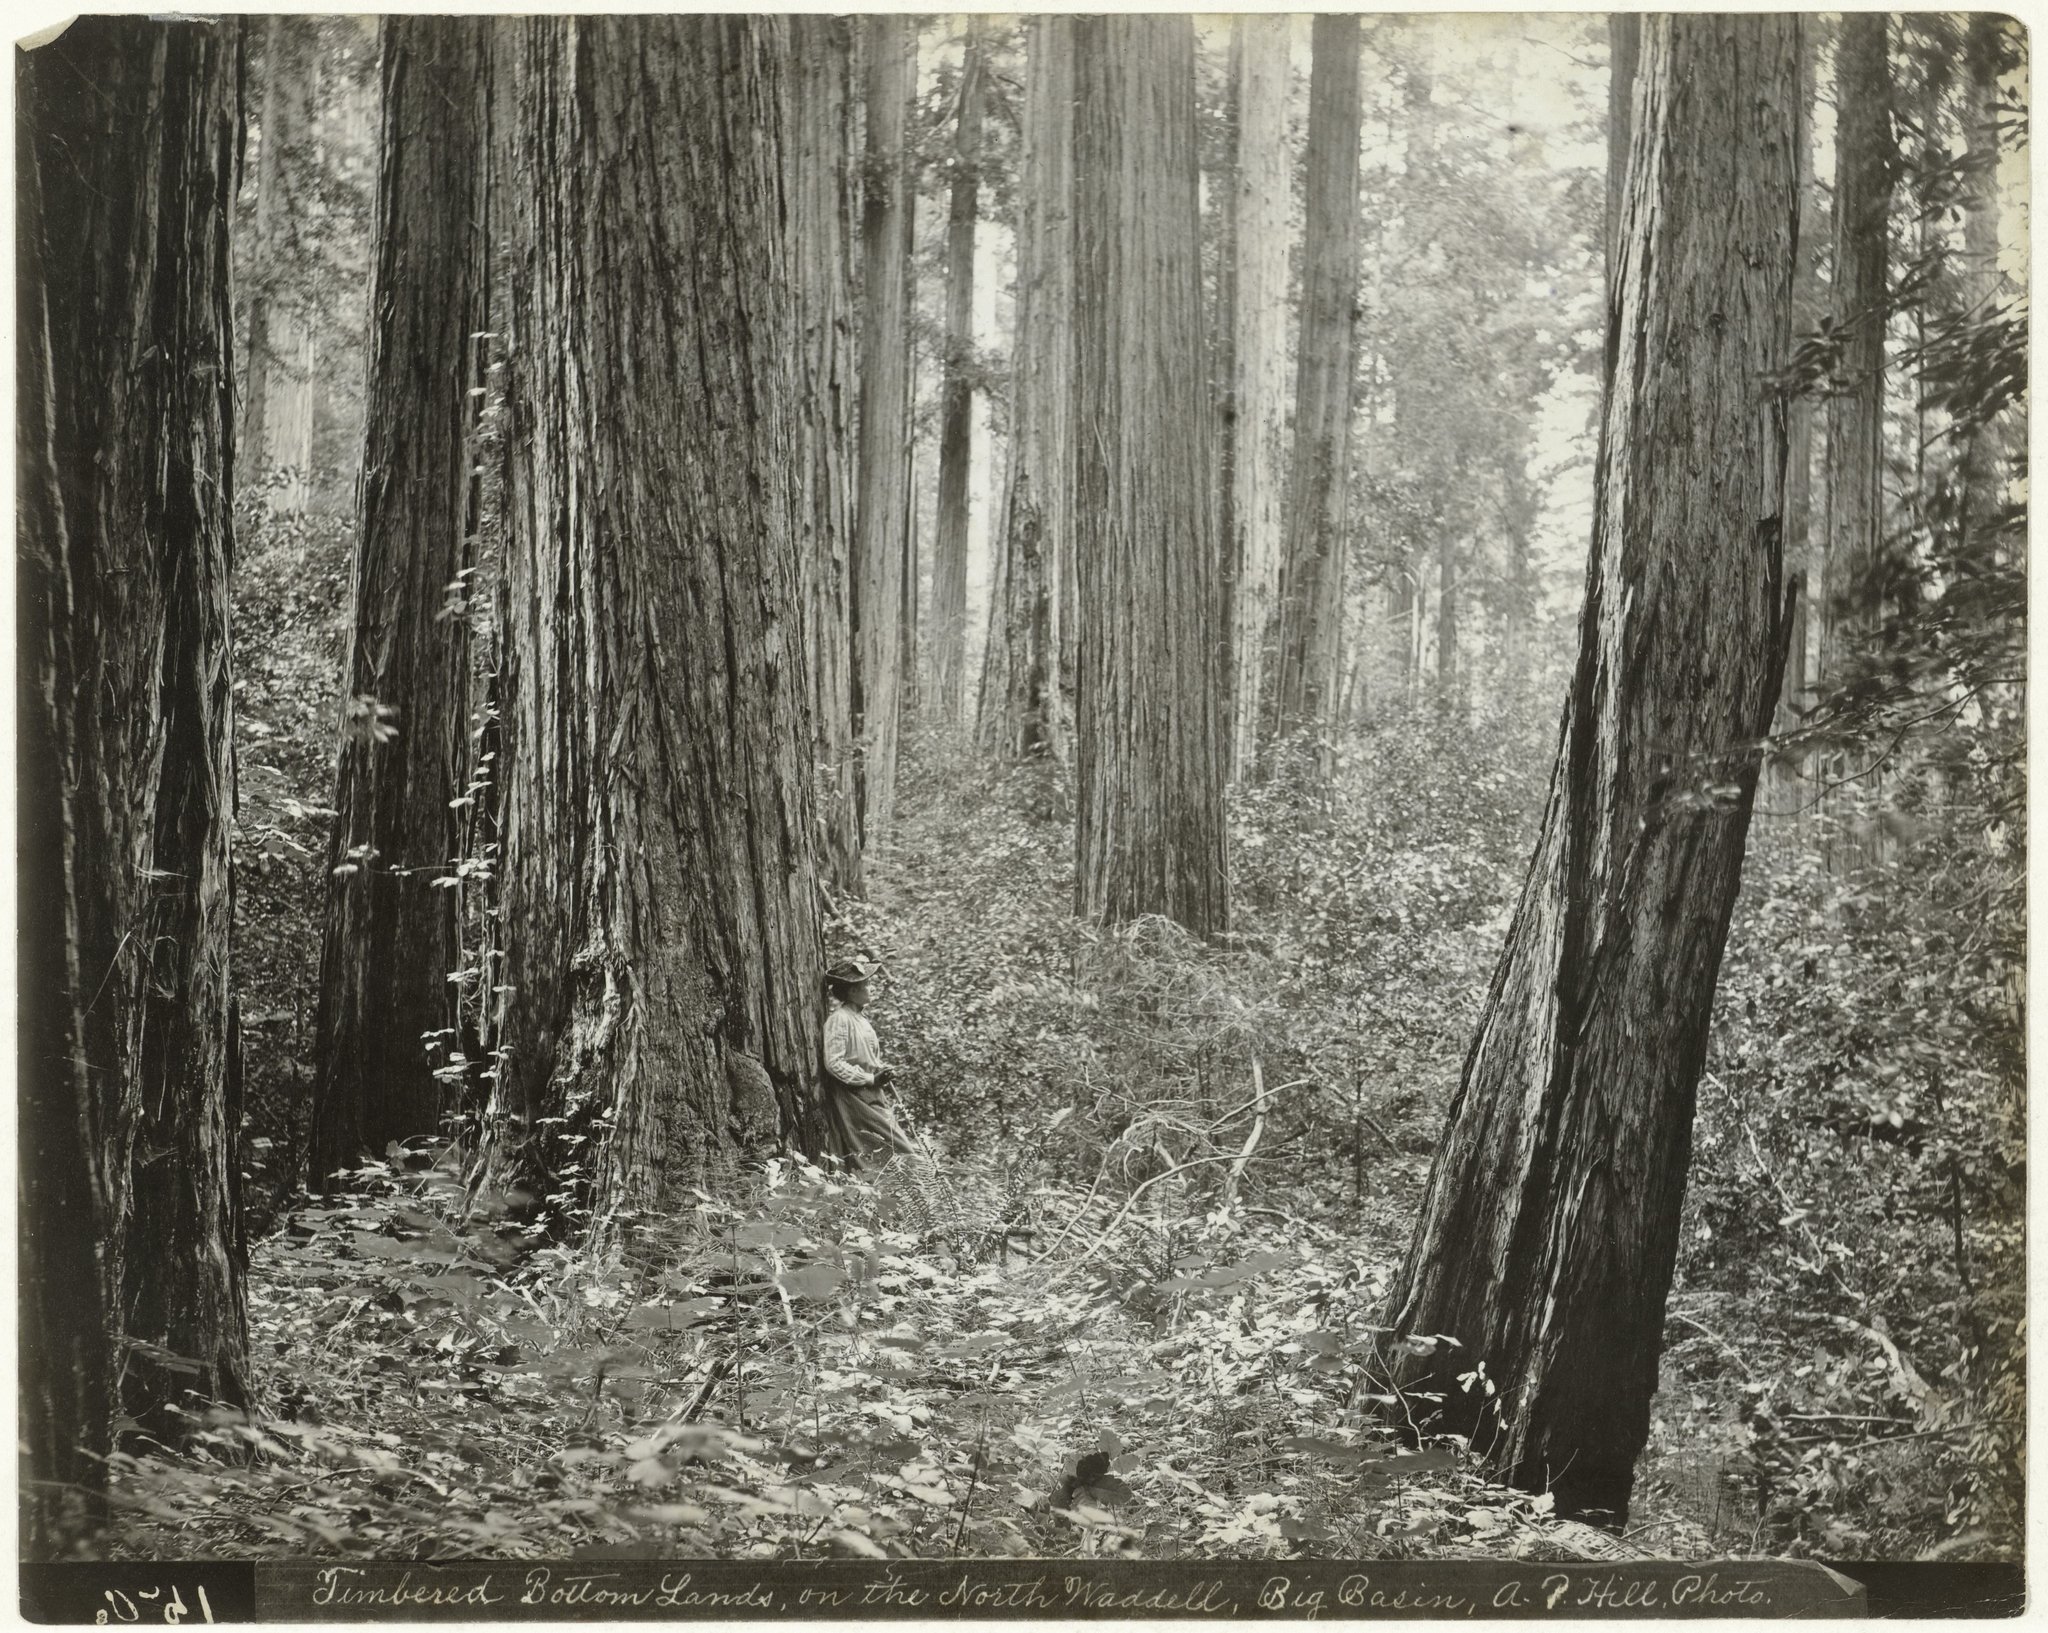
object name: photograph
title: Big Basin Redwoods Forest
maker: andrew p. hill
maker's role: painter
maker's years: 1853-1922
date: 1899-1900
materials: paper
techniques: matte daylight collodion silver print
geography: santa cruz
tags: trees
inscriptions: inscription: ‘Uncut forest lands, Big Basin’, address: ‘ANDREW P. HILL Photographer,/ 85 South Second Street/ Dougherty Bldg. SAN JOSE CAL.’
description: A painter and a photographer, Hill was also an activist. Together with others, including a journalist, from 1899 he led a successful effort to preserve the dense forest in Southern California. It was home to the tallest and oldest trees in the world. Project developers and railway magnates wanted to exploit the area of the Redwoods Forest, which became a national park thanks to Hill’s efforts. Hill photographed the forest and opened a store there to sell his pictures.